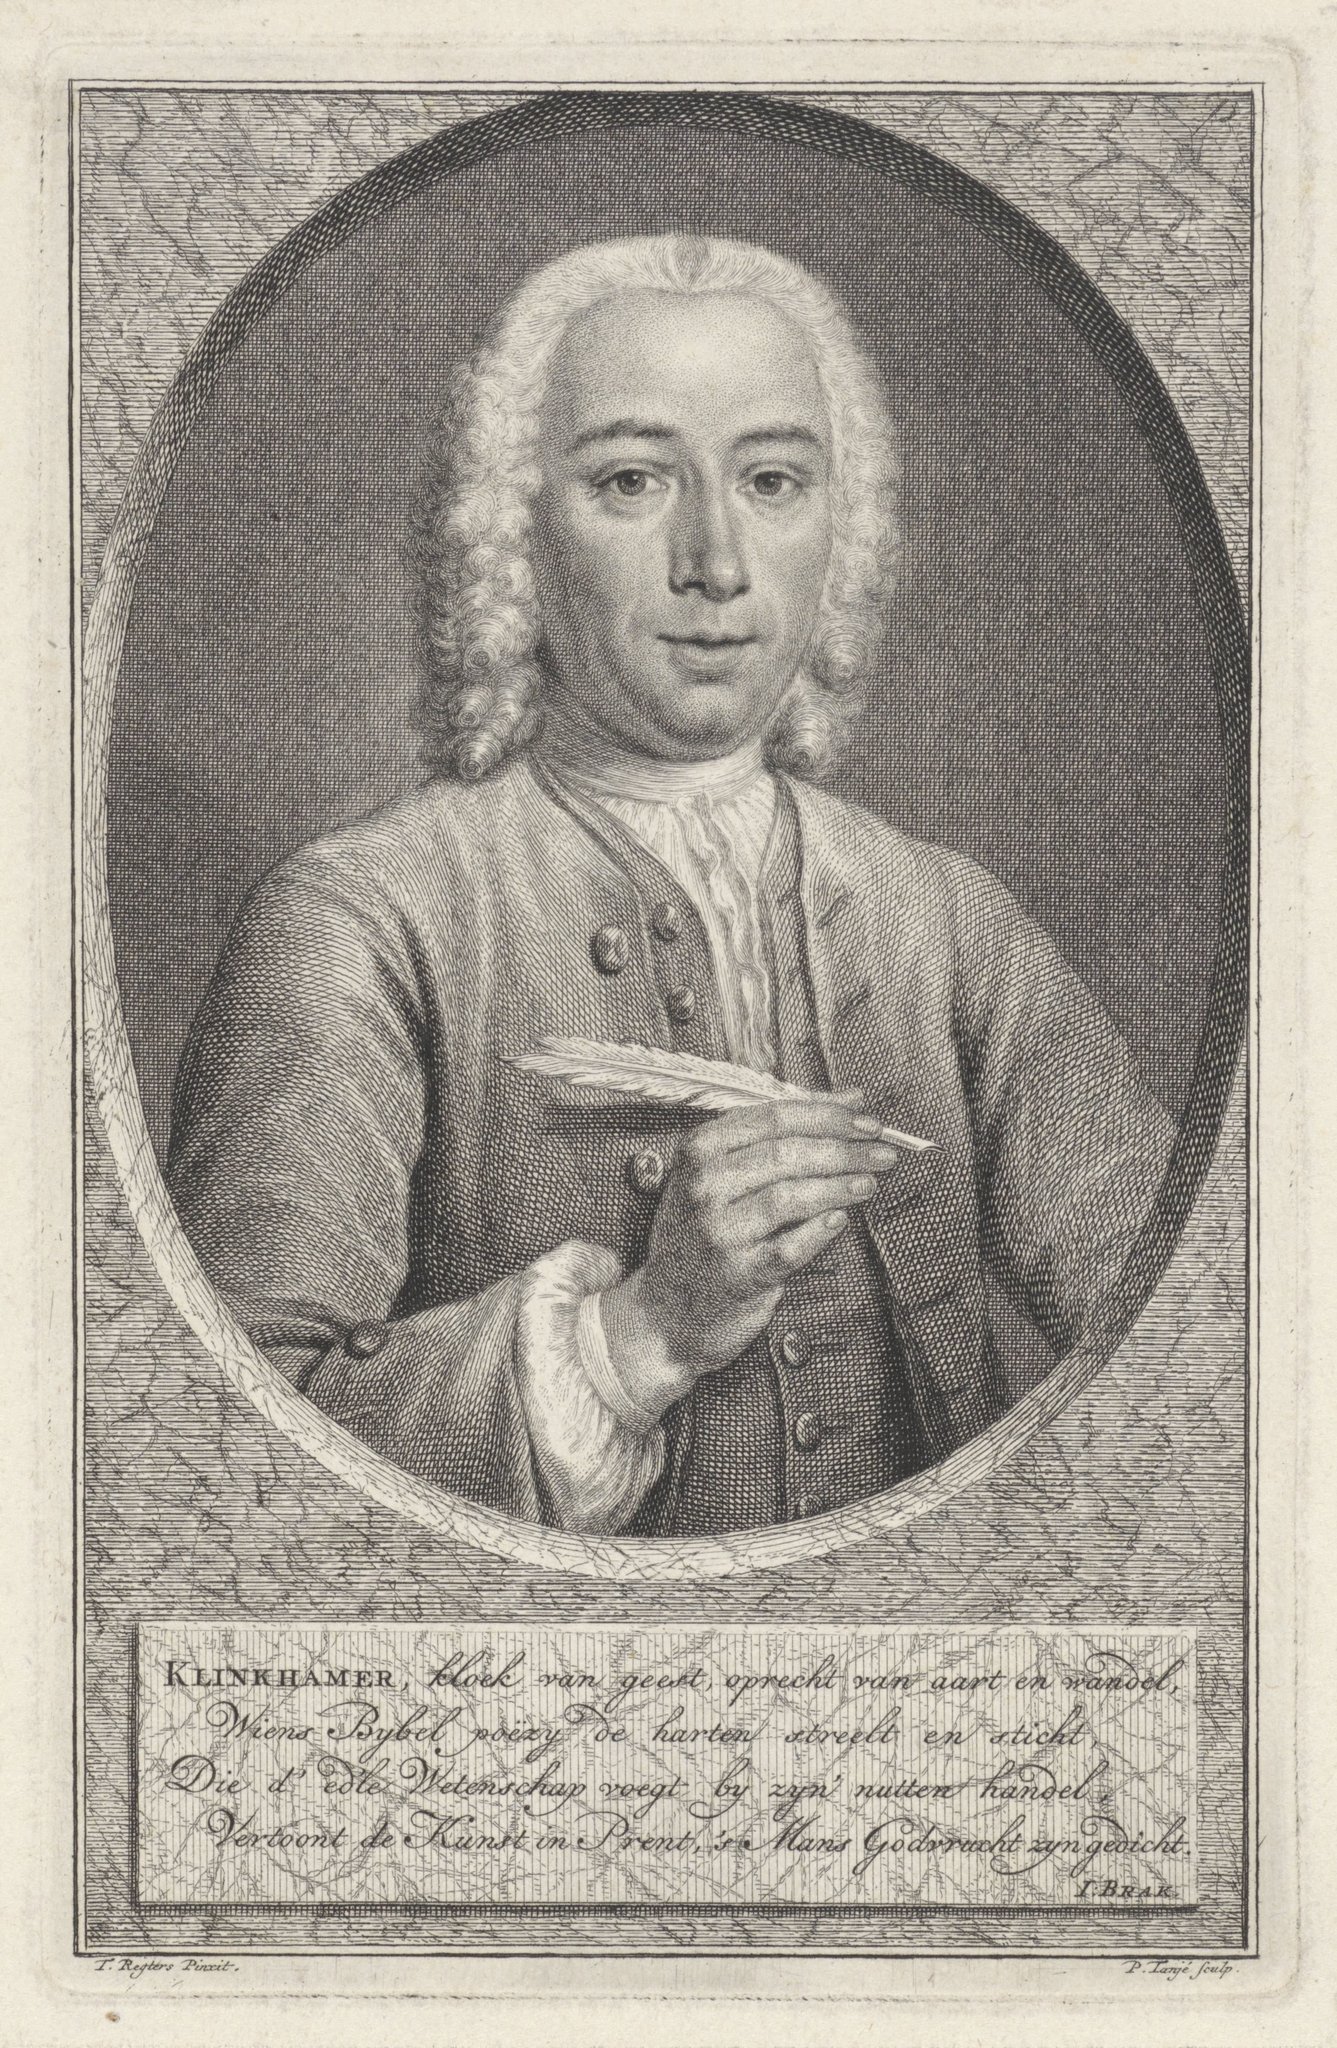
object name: print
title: Portret van Govert Klinkhamer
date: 1716-1761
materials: paper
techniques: engraving, etching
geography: amsterdam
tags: amsterdam, govert klinkhamer, quill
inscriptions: collector's mark: Lugt 2228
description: Portret van Govert Klinkhamer, dichter van Bijbelse gedichten, met een schrijfveer in de hand. Onder het portret een vierrregelig vers in het Nederlands.